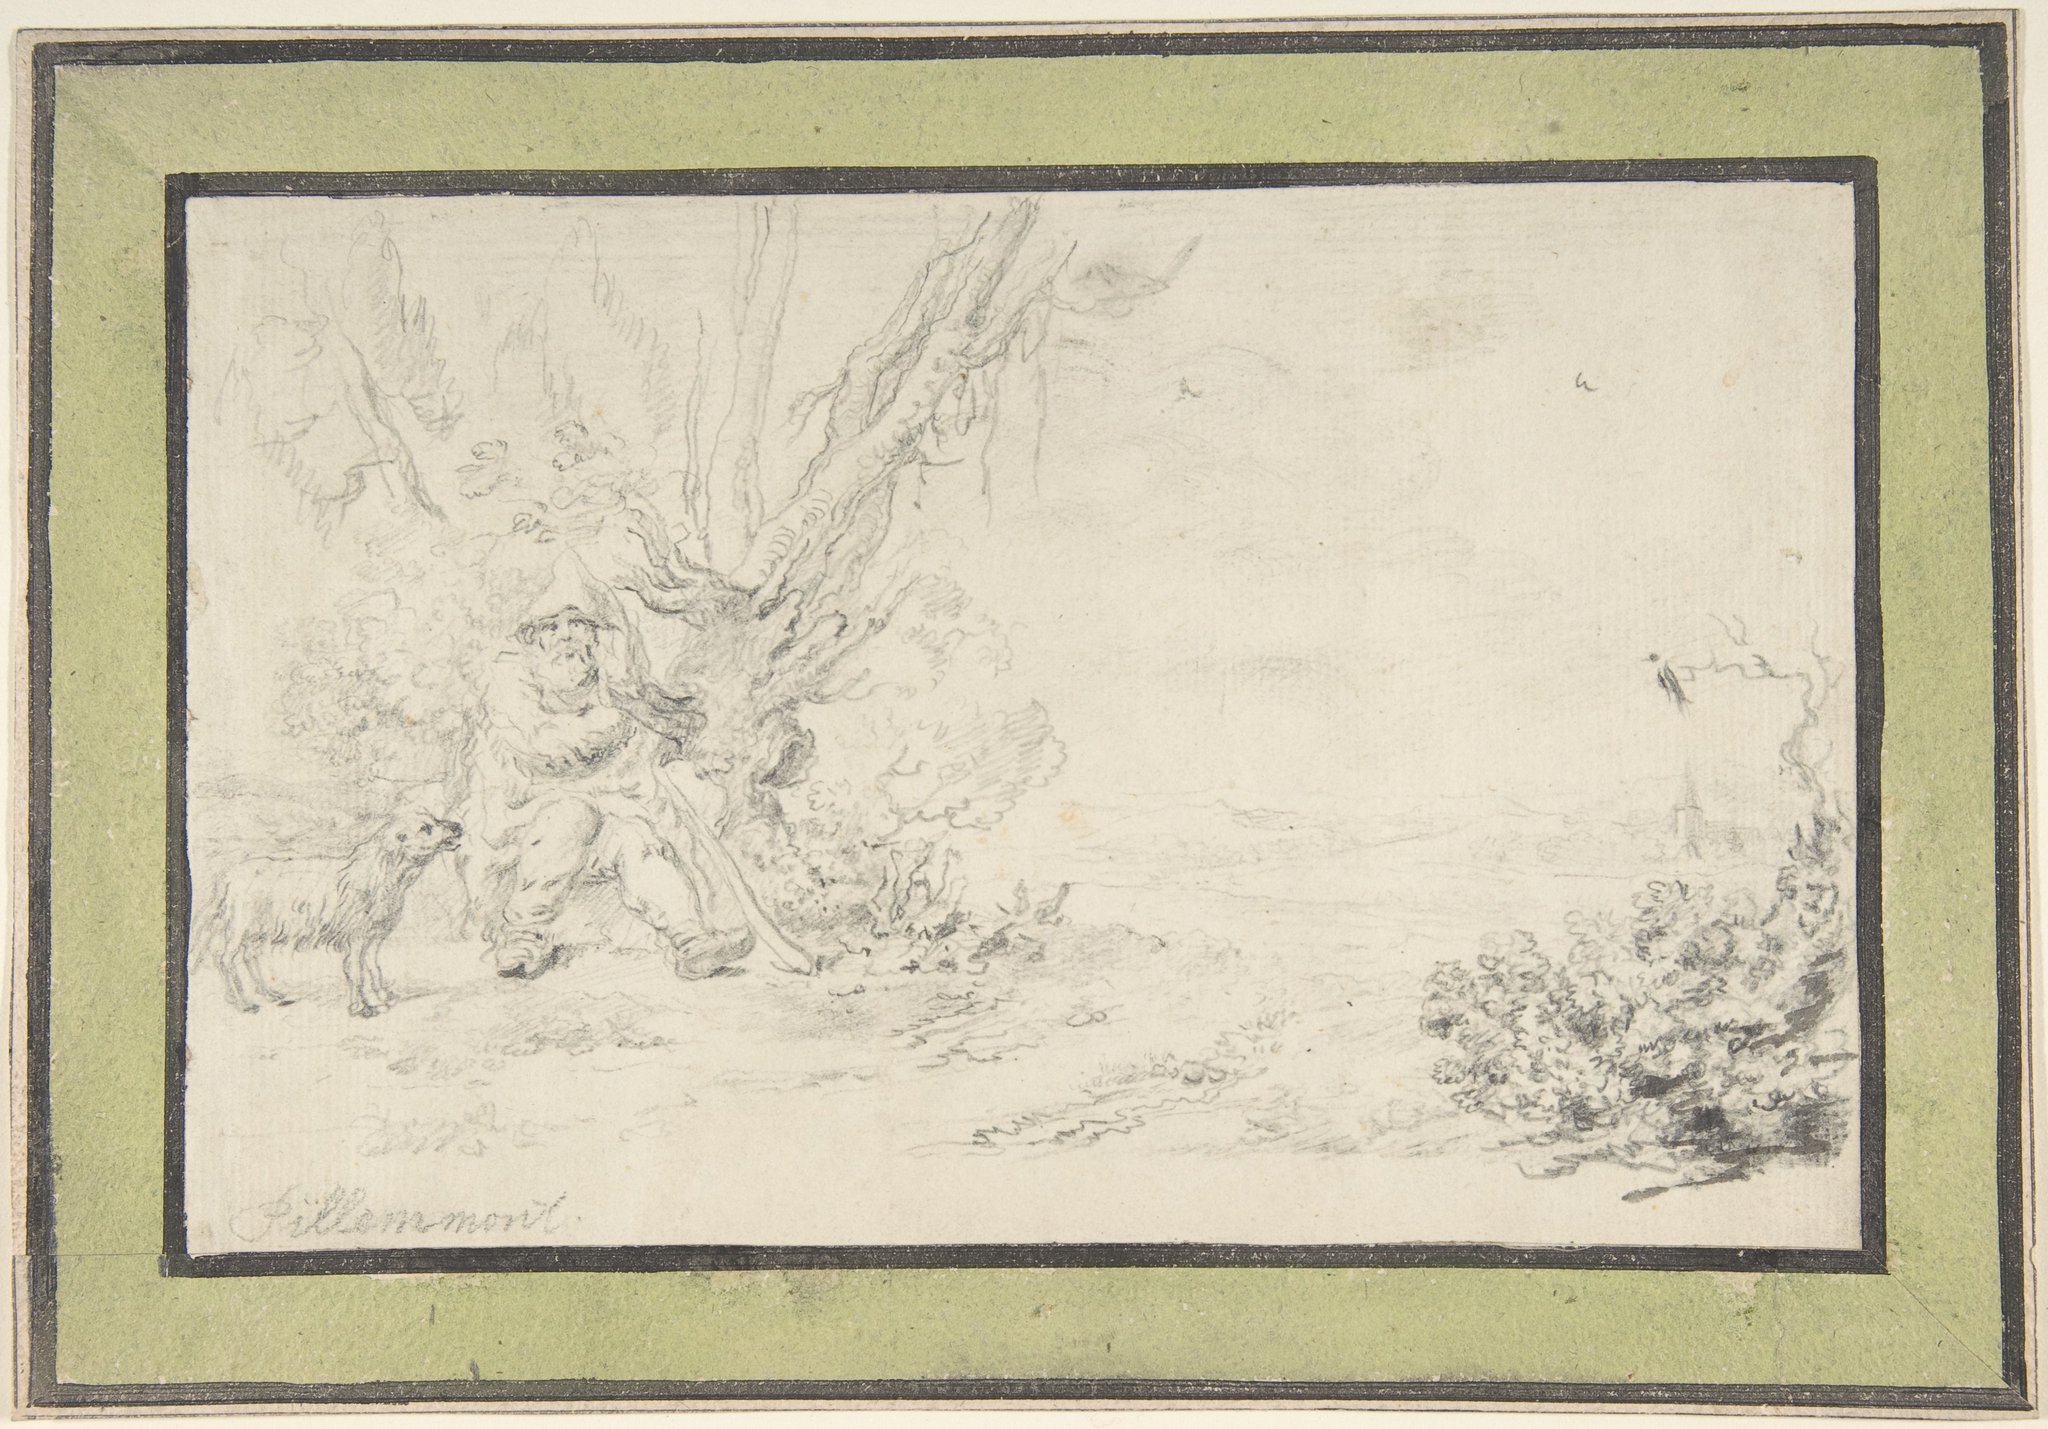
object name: drawing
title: Landscape with Seated Shepherd and Dog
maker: jean pillement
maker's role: artist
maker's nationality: french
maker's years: 1728-1808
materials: graphite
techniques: brush, wash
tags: dogs,landscapes,shepherds